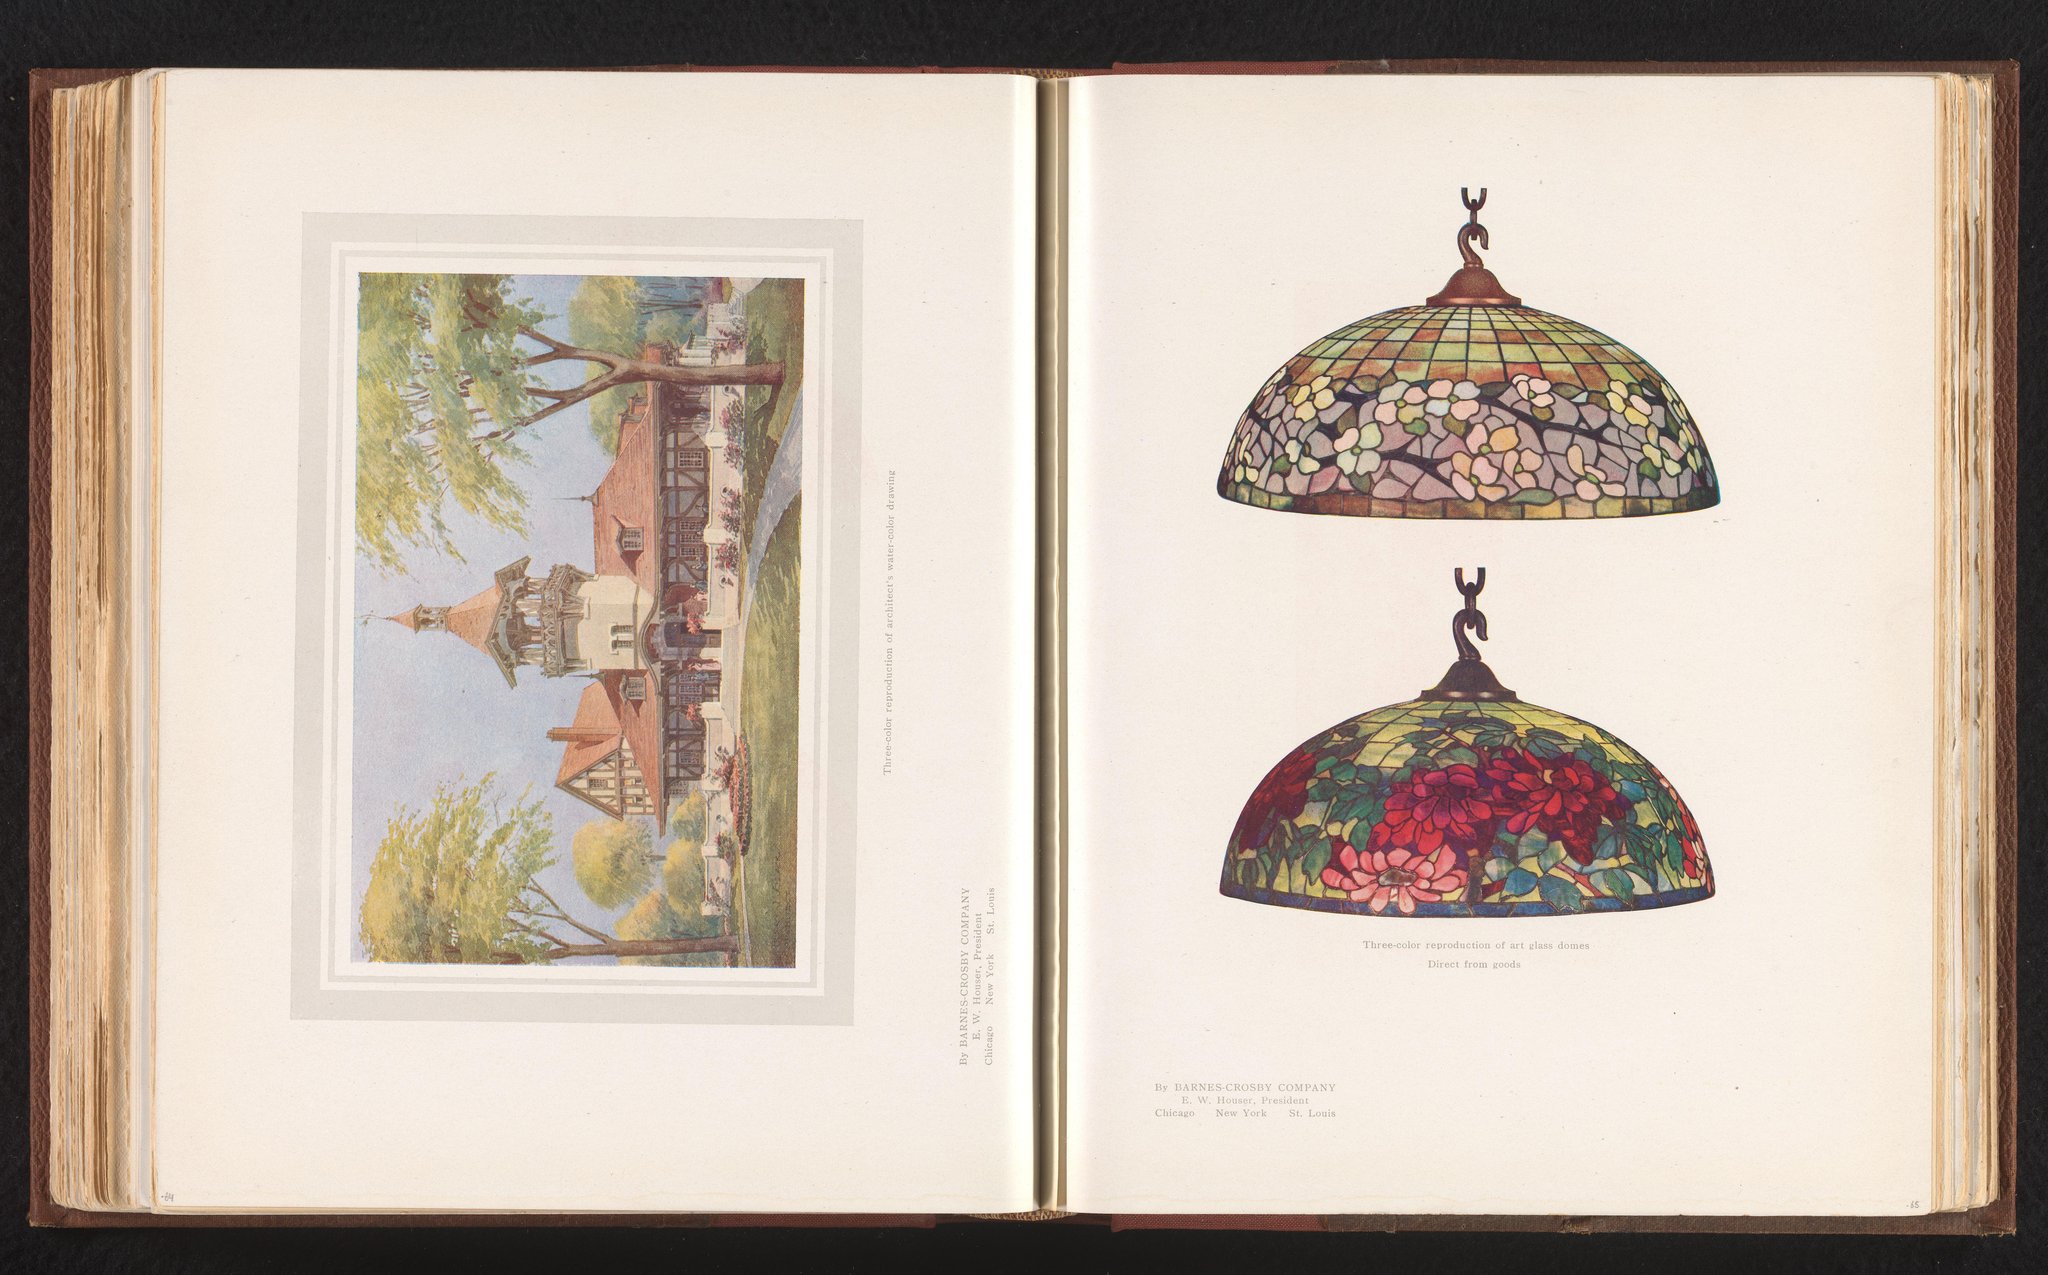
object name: page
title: Twee reproducties van lampenkappen met glas en lood in bloemmotief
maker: Anonymous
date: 1904-1909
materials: paper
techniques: three-color autotype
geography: united states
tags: lighting; lamps, stained-glass artist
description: Prent op derde ongenummerde pagina na pagina 270.